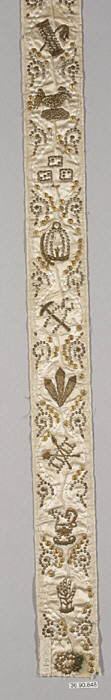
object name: piece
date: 1701-1800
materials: metal thread, silk